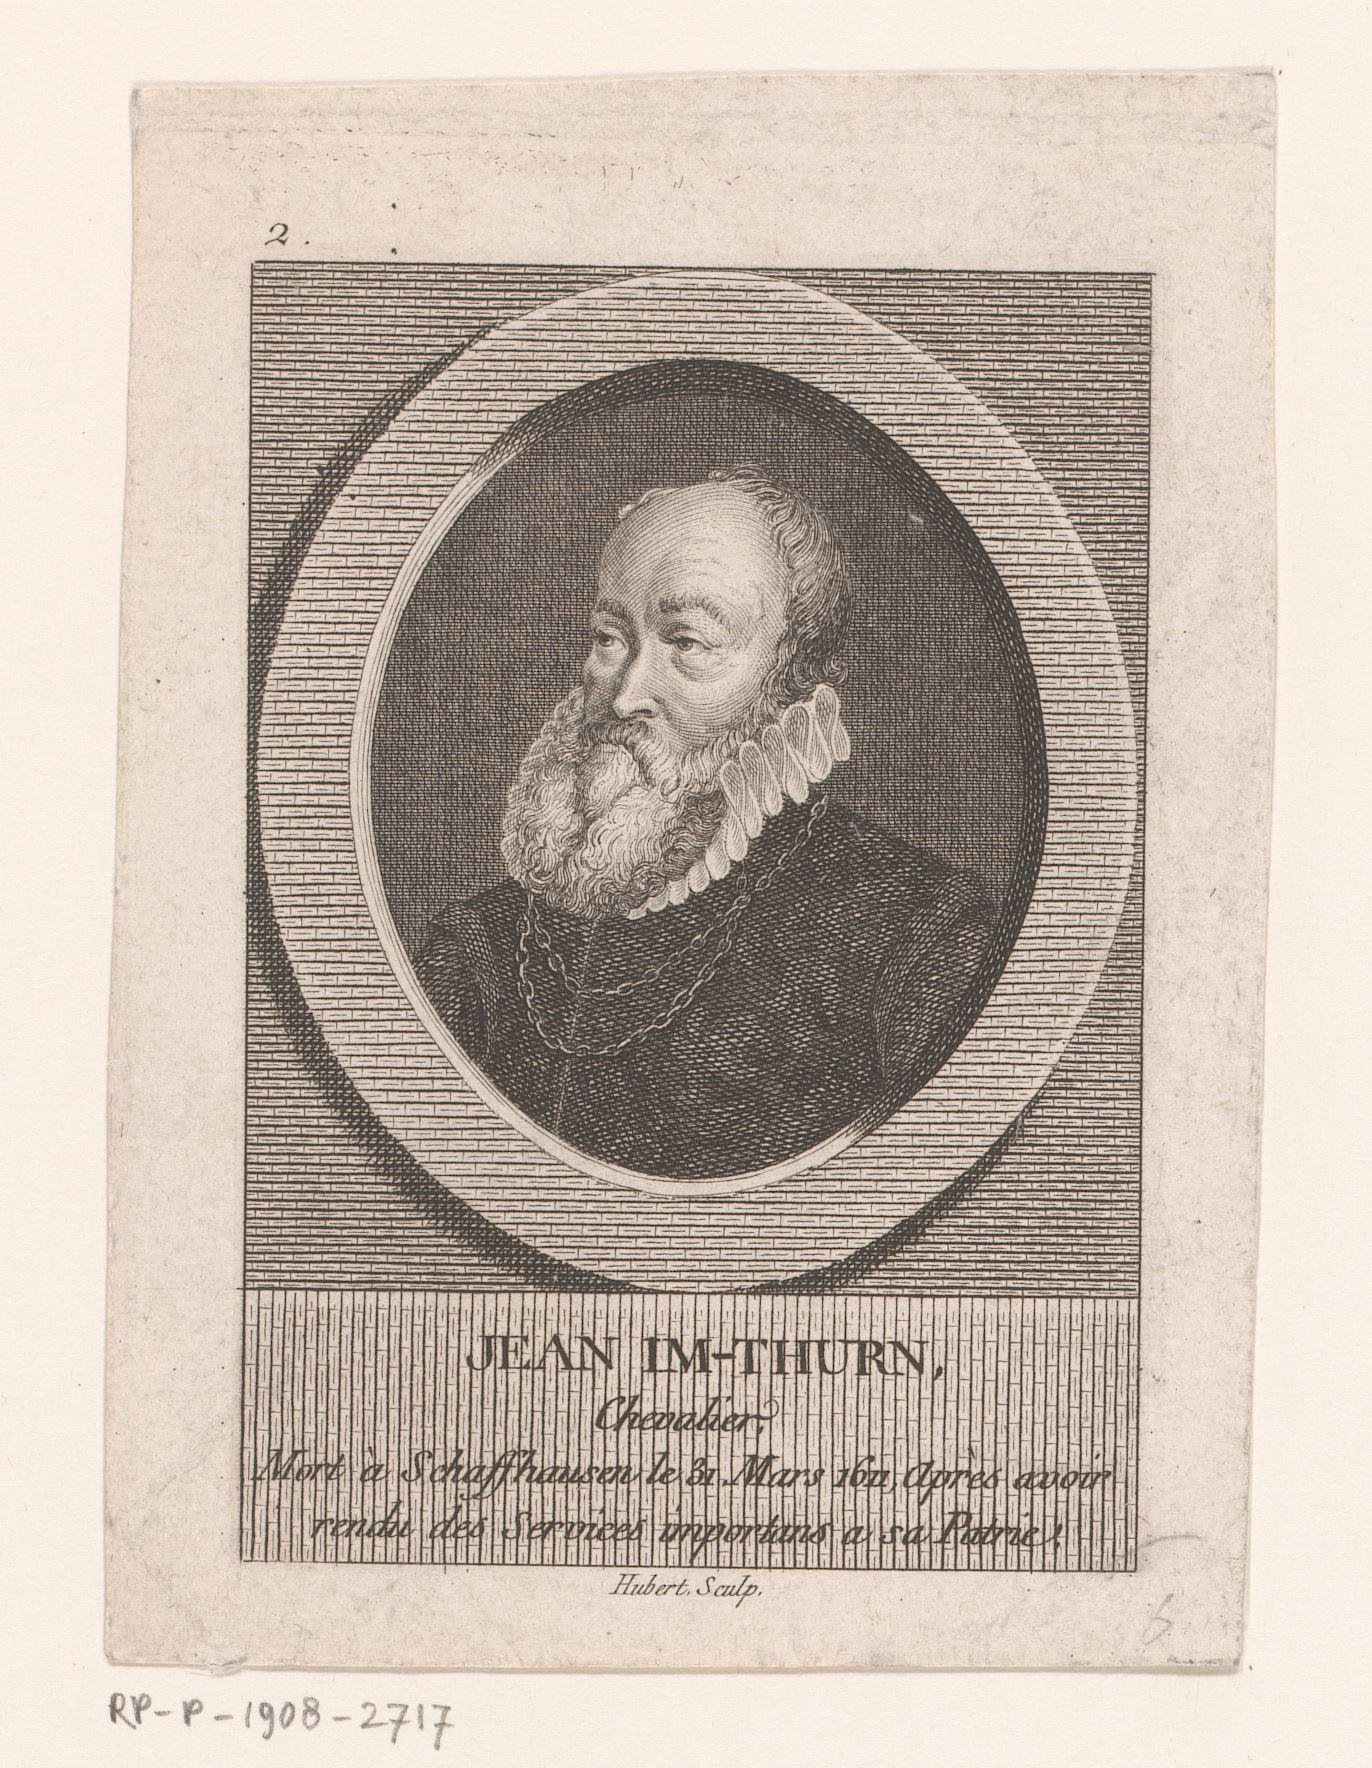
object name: book illustration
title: Portret van Jean Im-Thurn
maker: françois hubert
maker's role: print maker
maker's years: 1744-1809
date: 1784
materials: paper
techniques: etching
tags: historical persons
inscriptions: collector's mark: Lugt 2228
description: Prent uit: Laborde, Jean-Benjamin de & Zurlauben, Beat Fidel. Tableaux topographiques, pittoresques, physiques, historiques, moraux, politiques, littéraires de la Suisse. Parijs: Lamy de Clousier, 1780-1786, dl. 3.